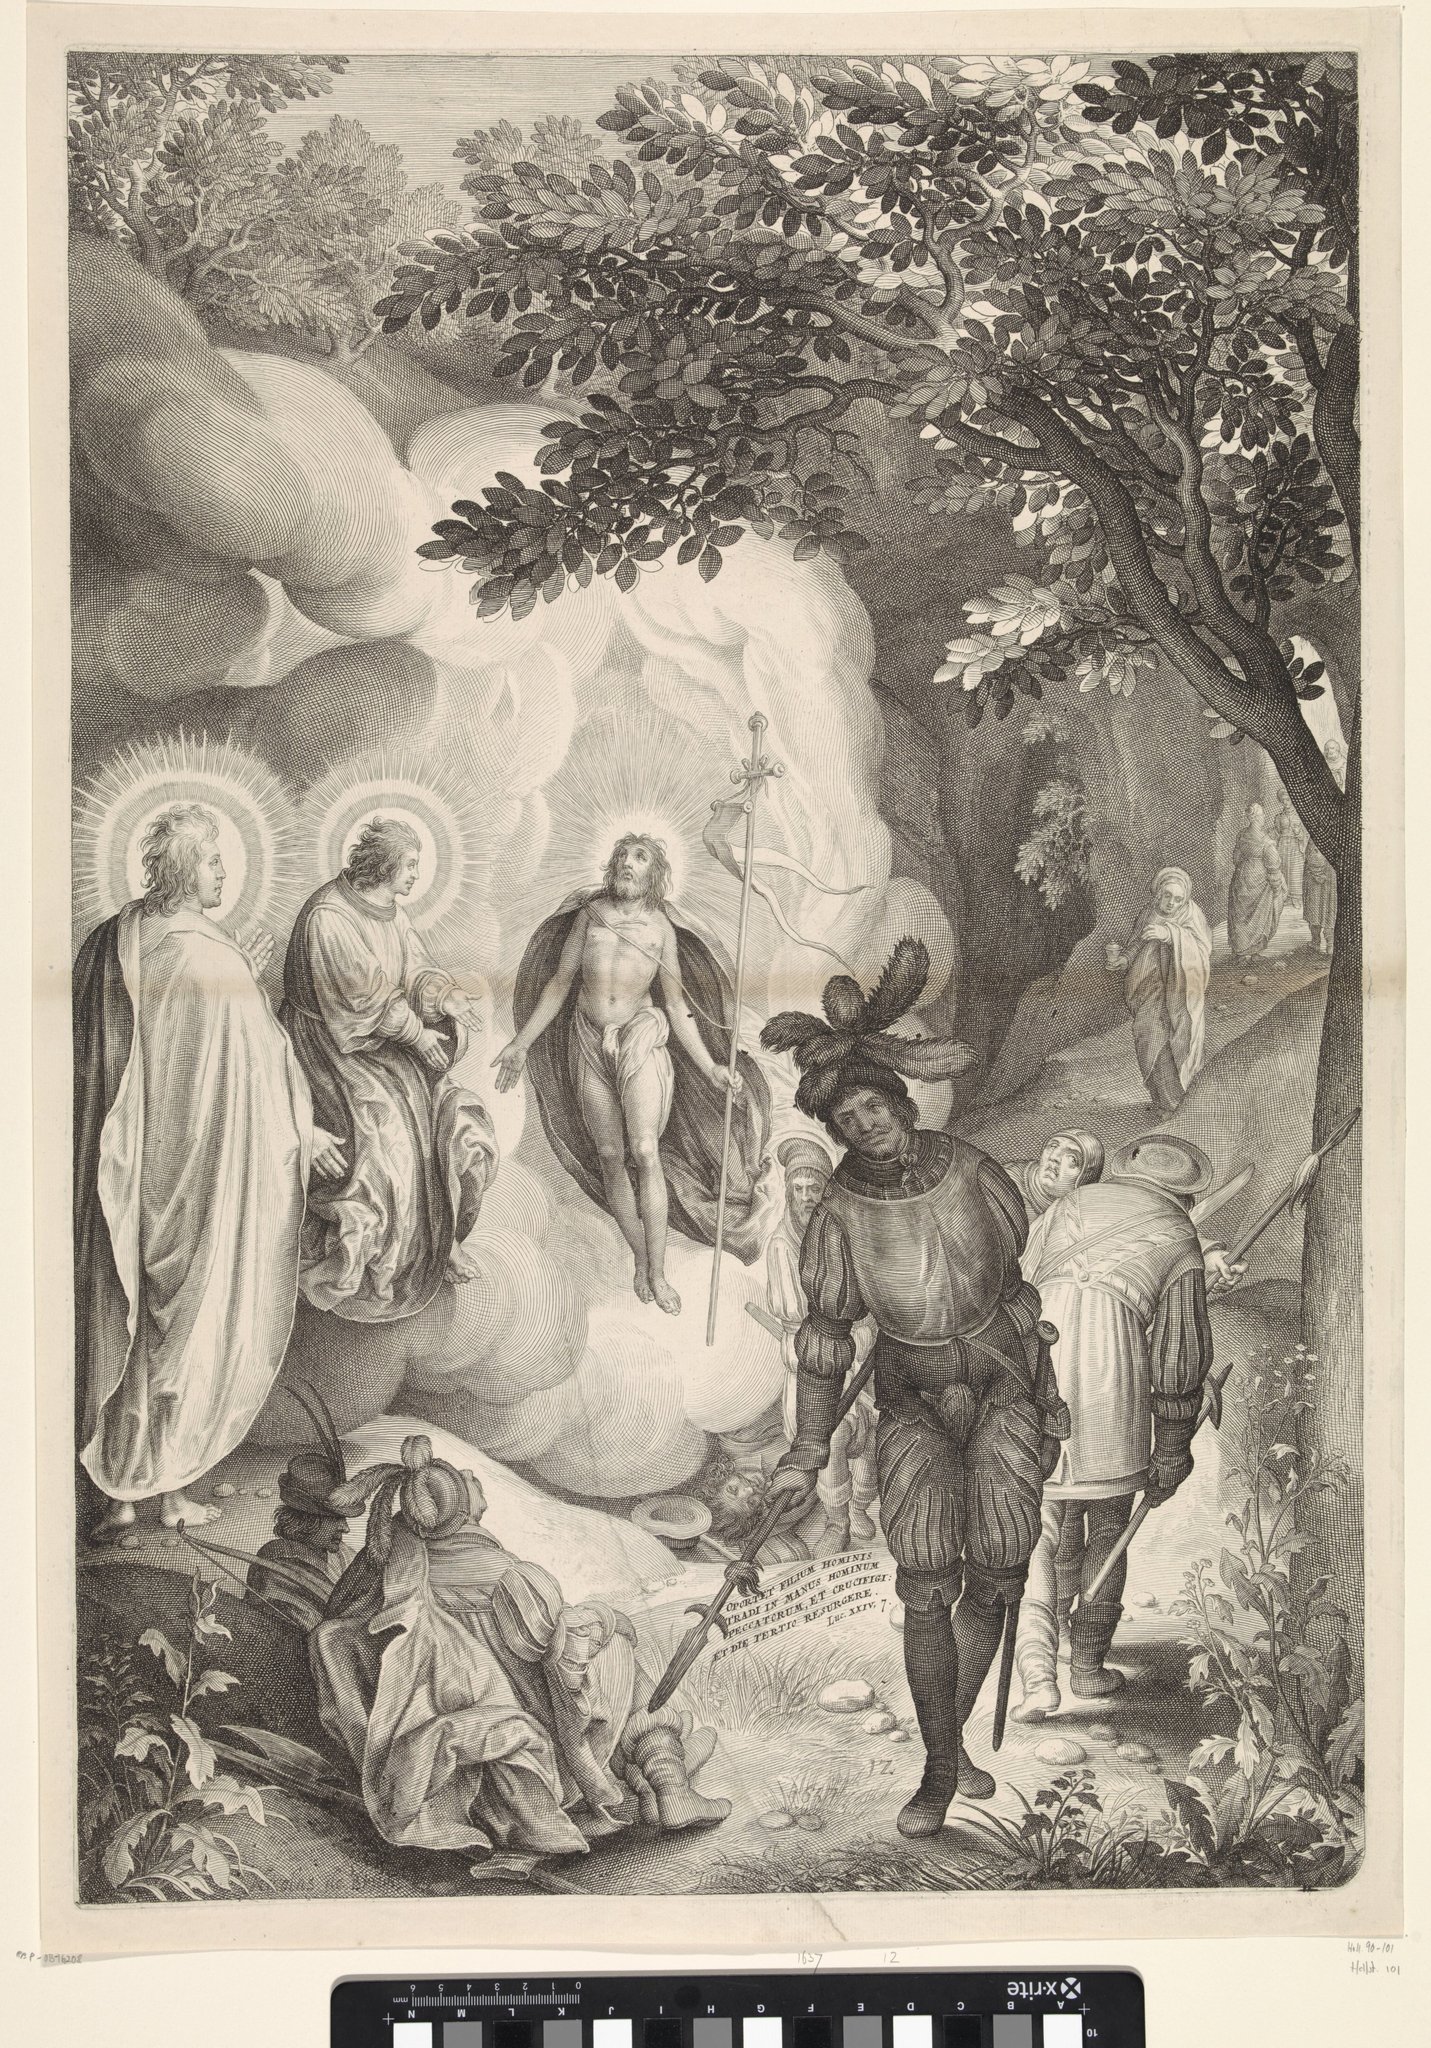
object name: print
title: Opstanding van Christus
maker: nicolaes de bruyn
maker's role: print maker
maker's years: 1571-1656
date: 1637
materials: paper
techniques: engraving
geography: rotterdam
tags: the holy women (the three maries) on their way to or at the tomb, to anoint christ's body, christ, usually holding a banner, arises from the grave; often combined with sleeping and/or frightened soldiers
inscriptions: date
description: Christus verrijst uit zijn graf. Rondom het graf slapende soldaten. Links de twee engelen die de opstanding aan de drie Maria's gaan verkondigen. Rechts de aankomst van de drie heilige vrouwen bij het graf.